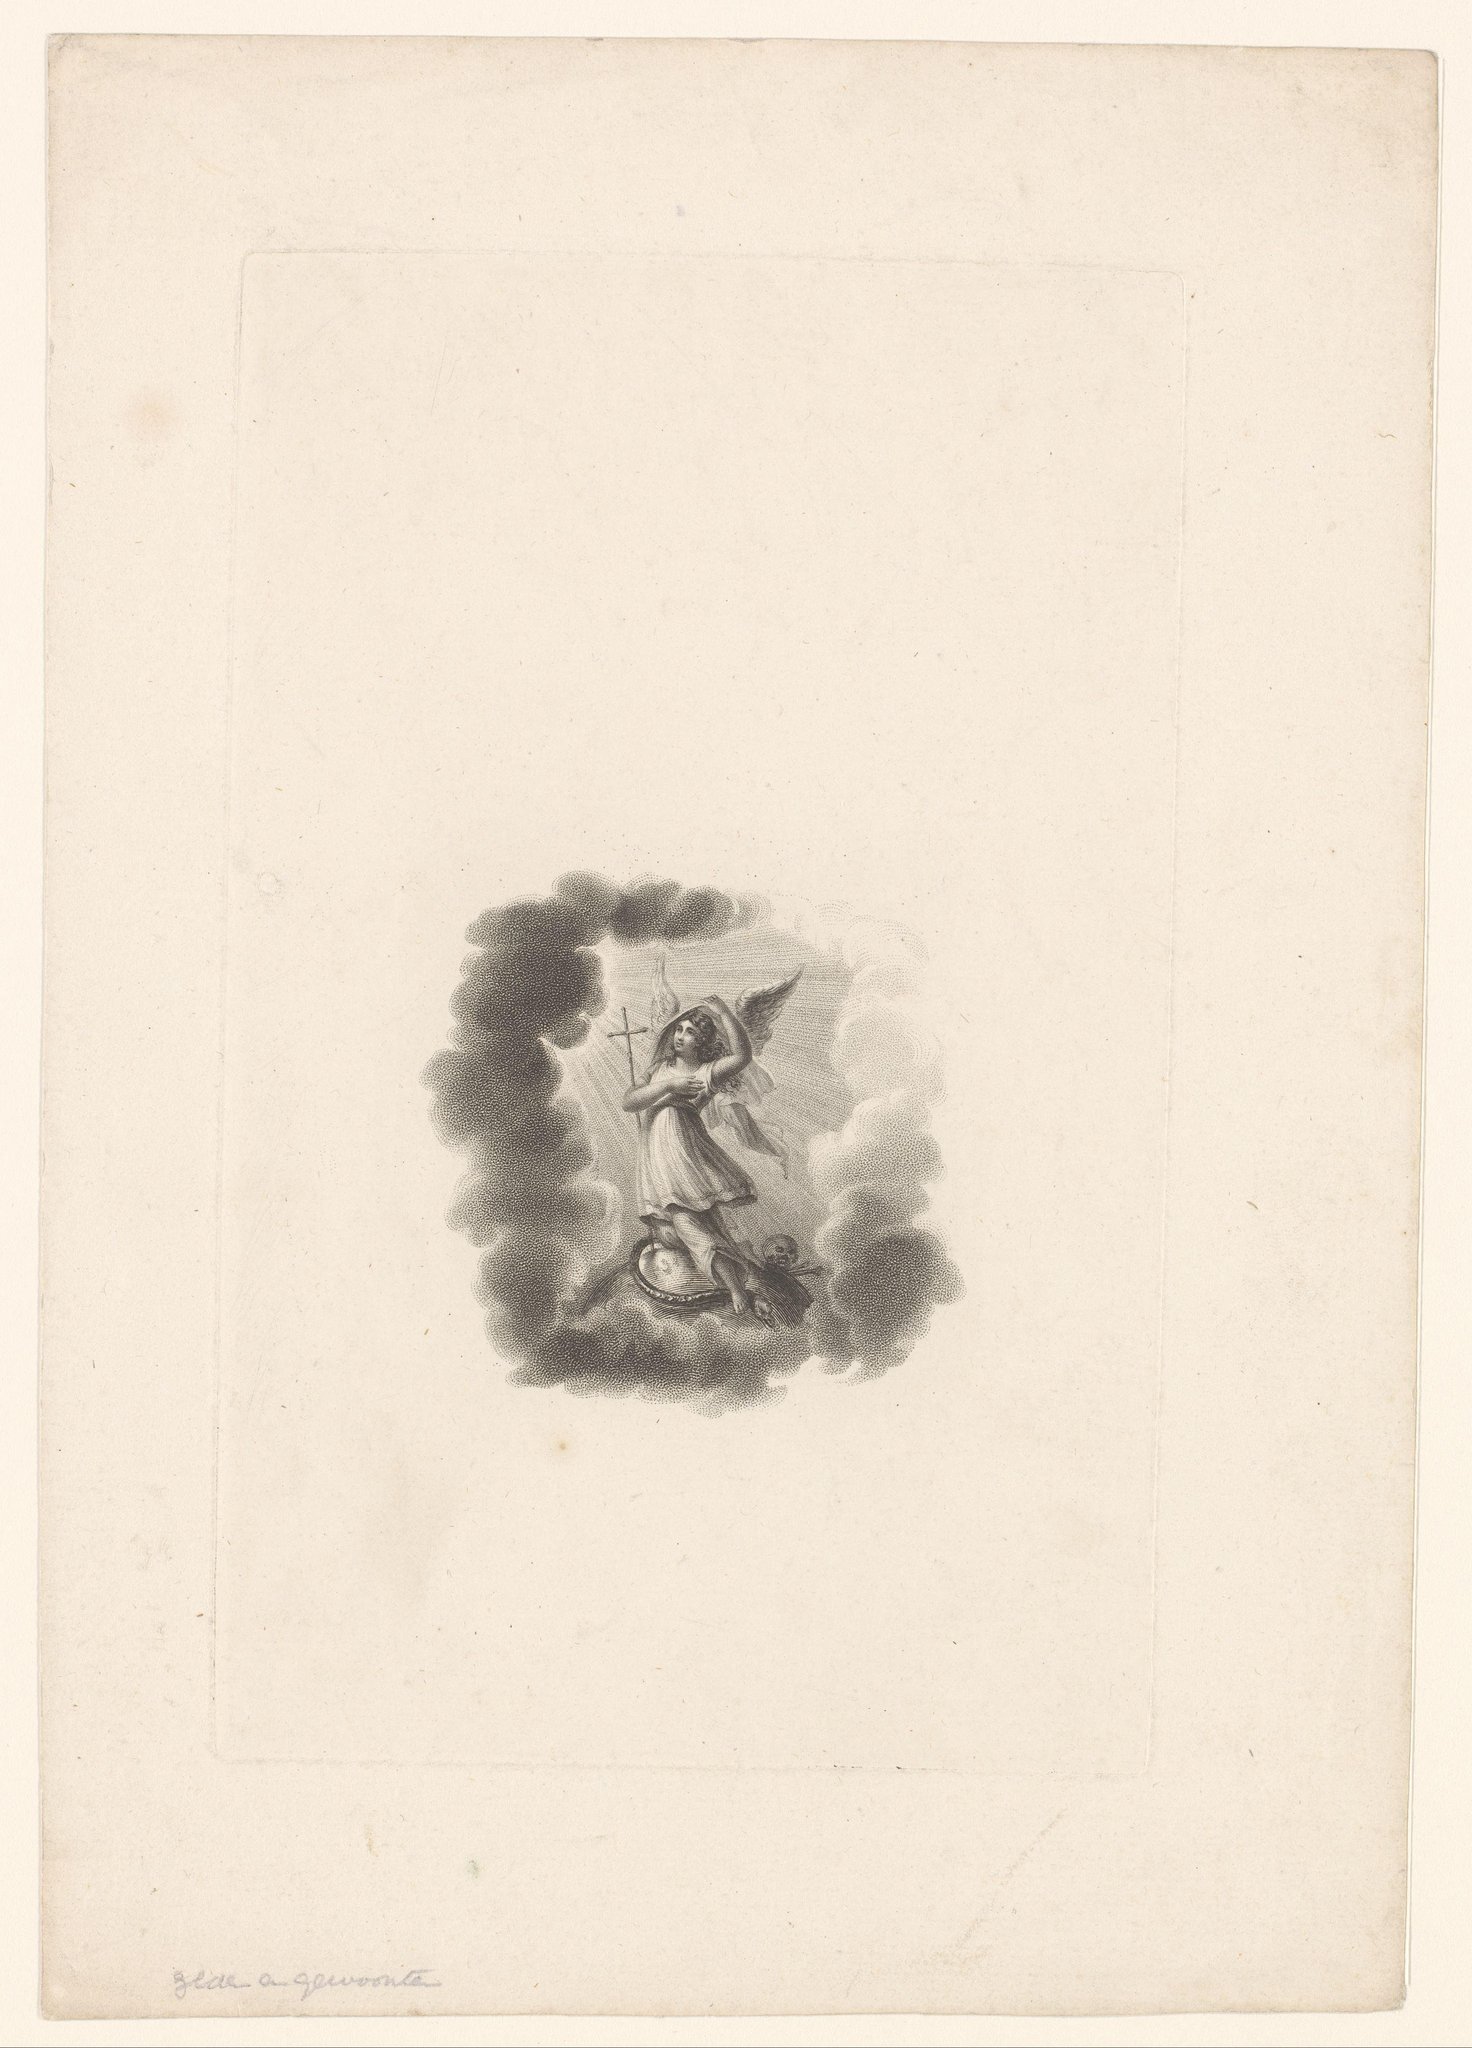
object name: print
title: Engel vertrapt een slang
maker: Anonymous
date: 1750-1850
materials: paper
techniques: etching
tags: the archangel michael (often in armour with sword or lance), angels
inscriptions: collector's mark: Lugt 2228